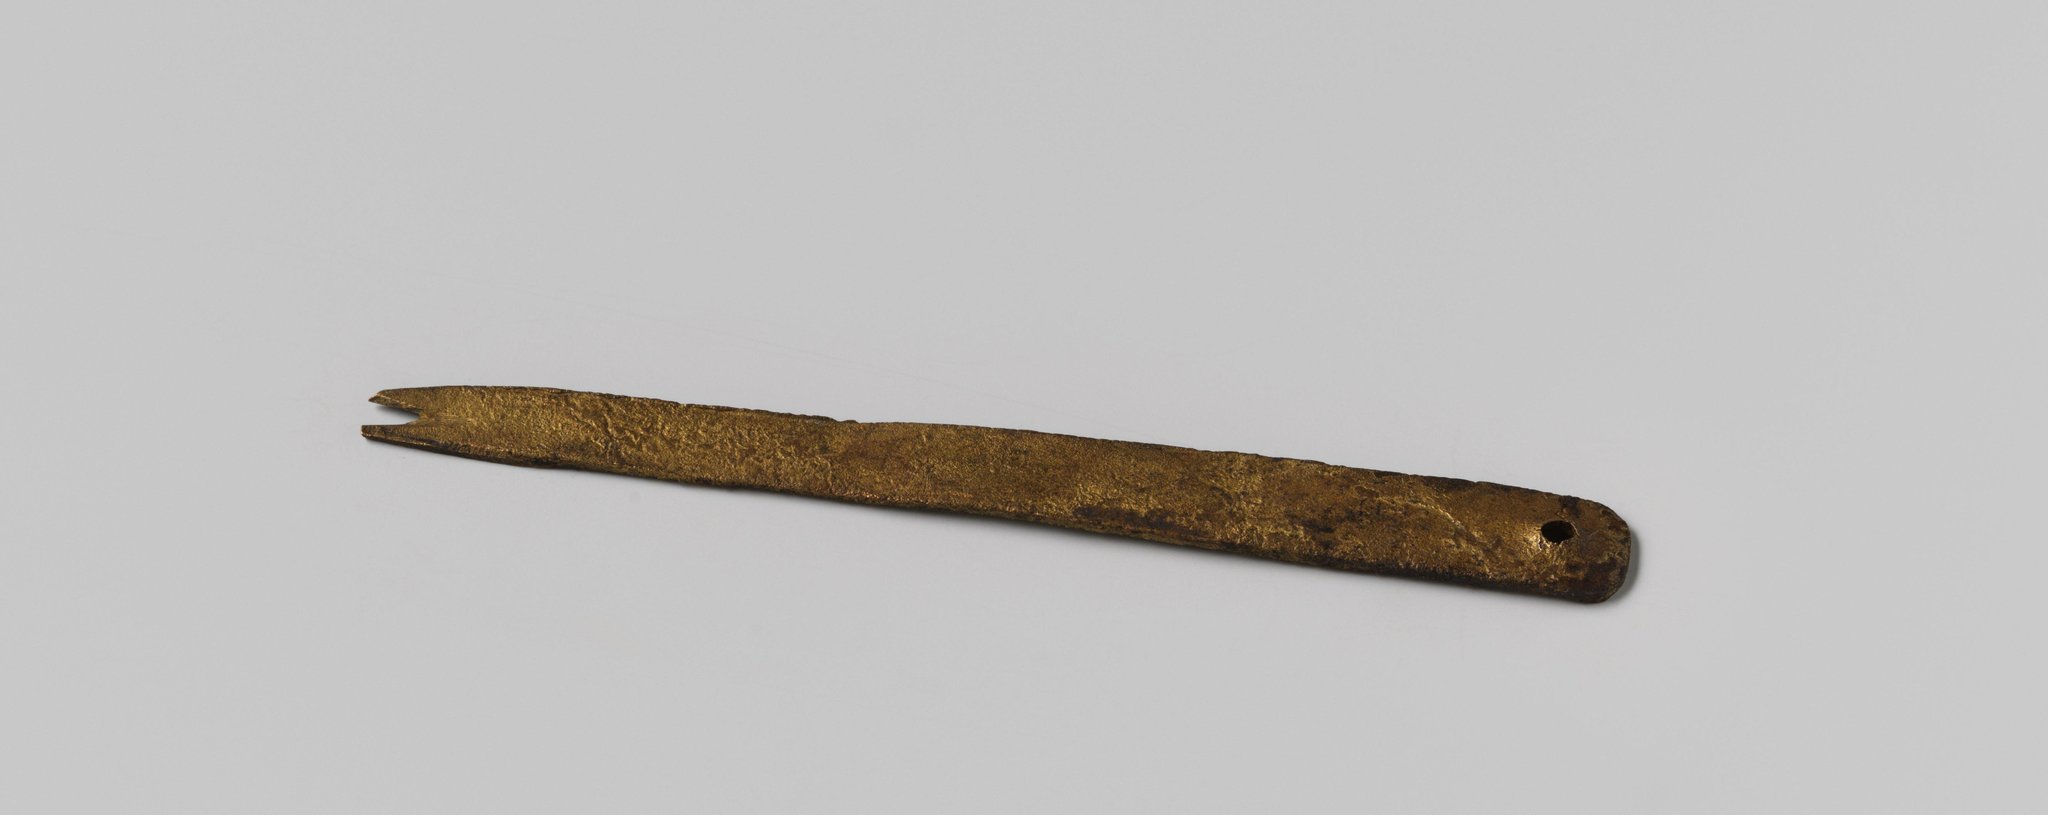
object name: fragment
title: Fragment van koper uit het wrak van de Oost-Indiëvaarder Hollandia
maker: Anonymous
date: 1700-1743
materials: copper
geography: netherlands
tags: verenigde oostindische compagnie, hollandia (schip), annet